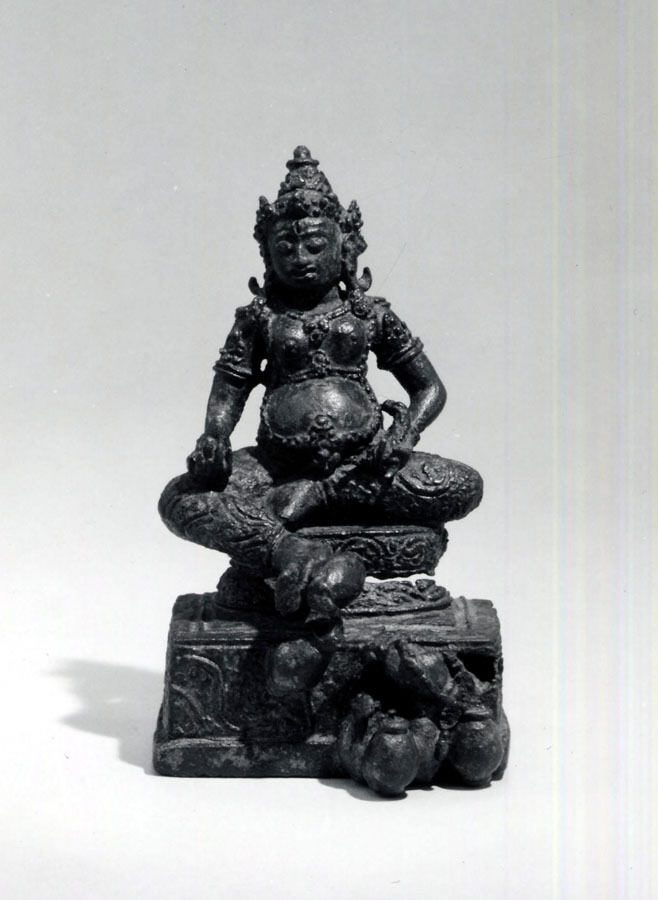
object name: figure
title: Seated Kubera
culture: indonesian, javanese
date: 1001-1100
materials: bronze